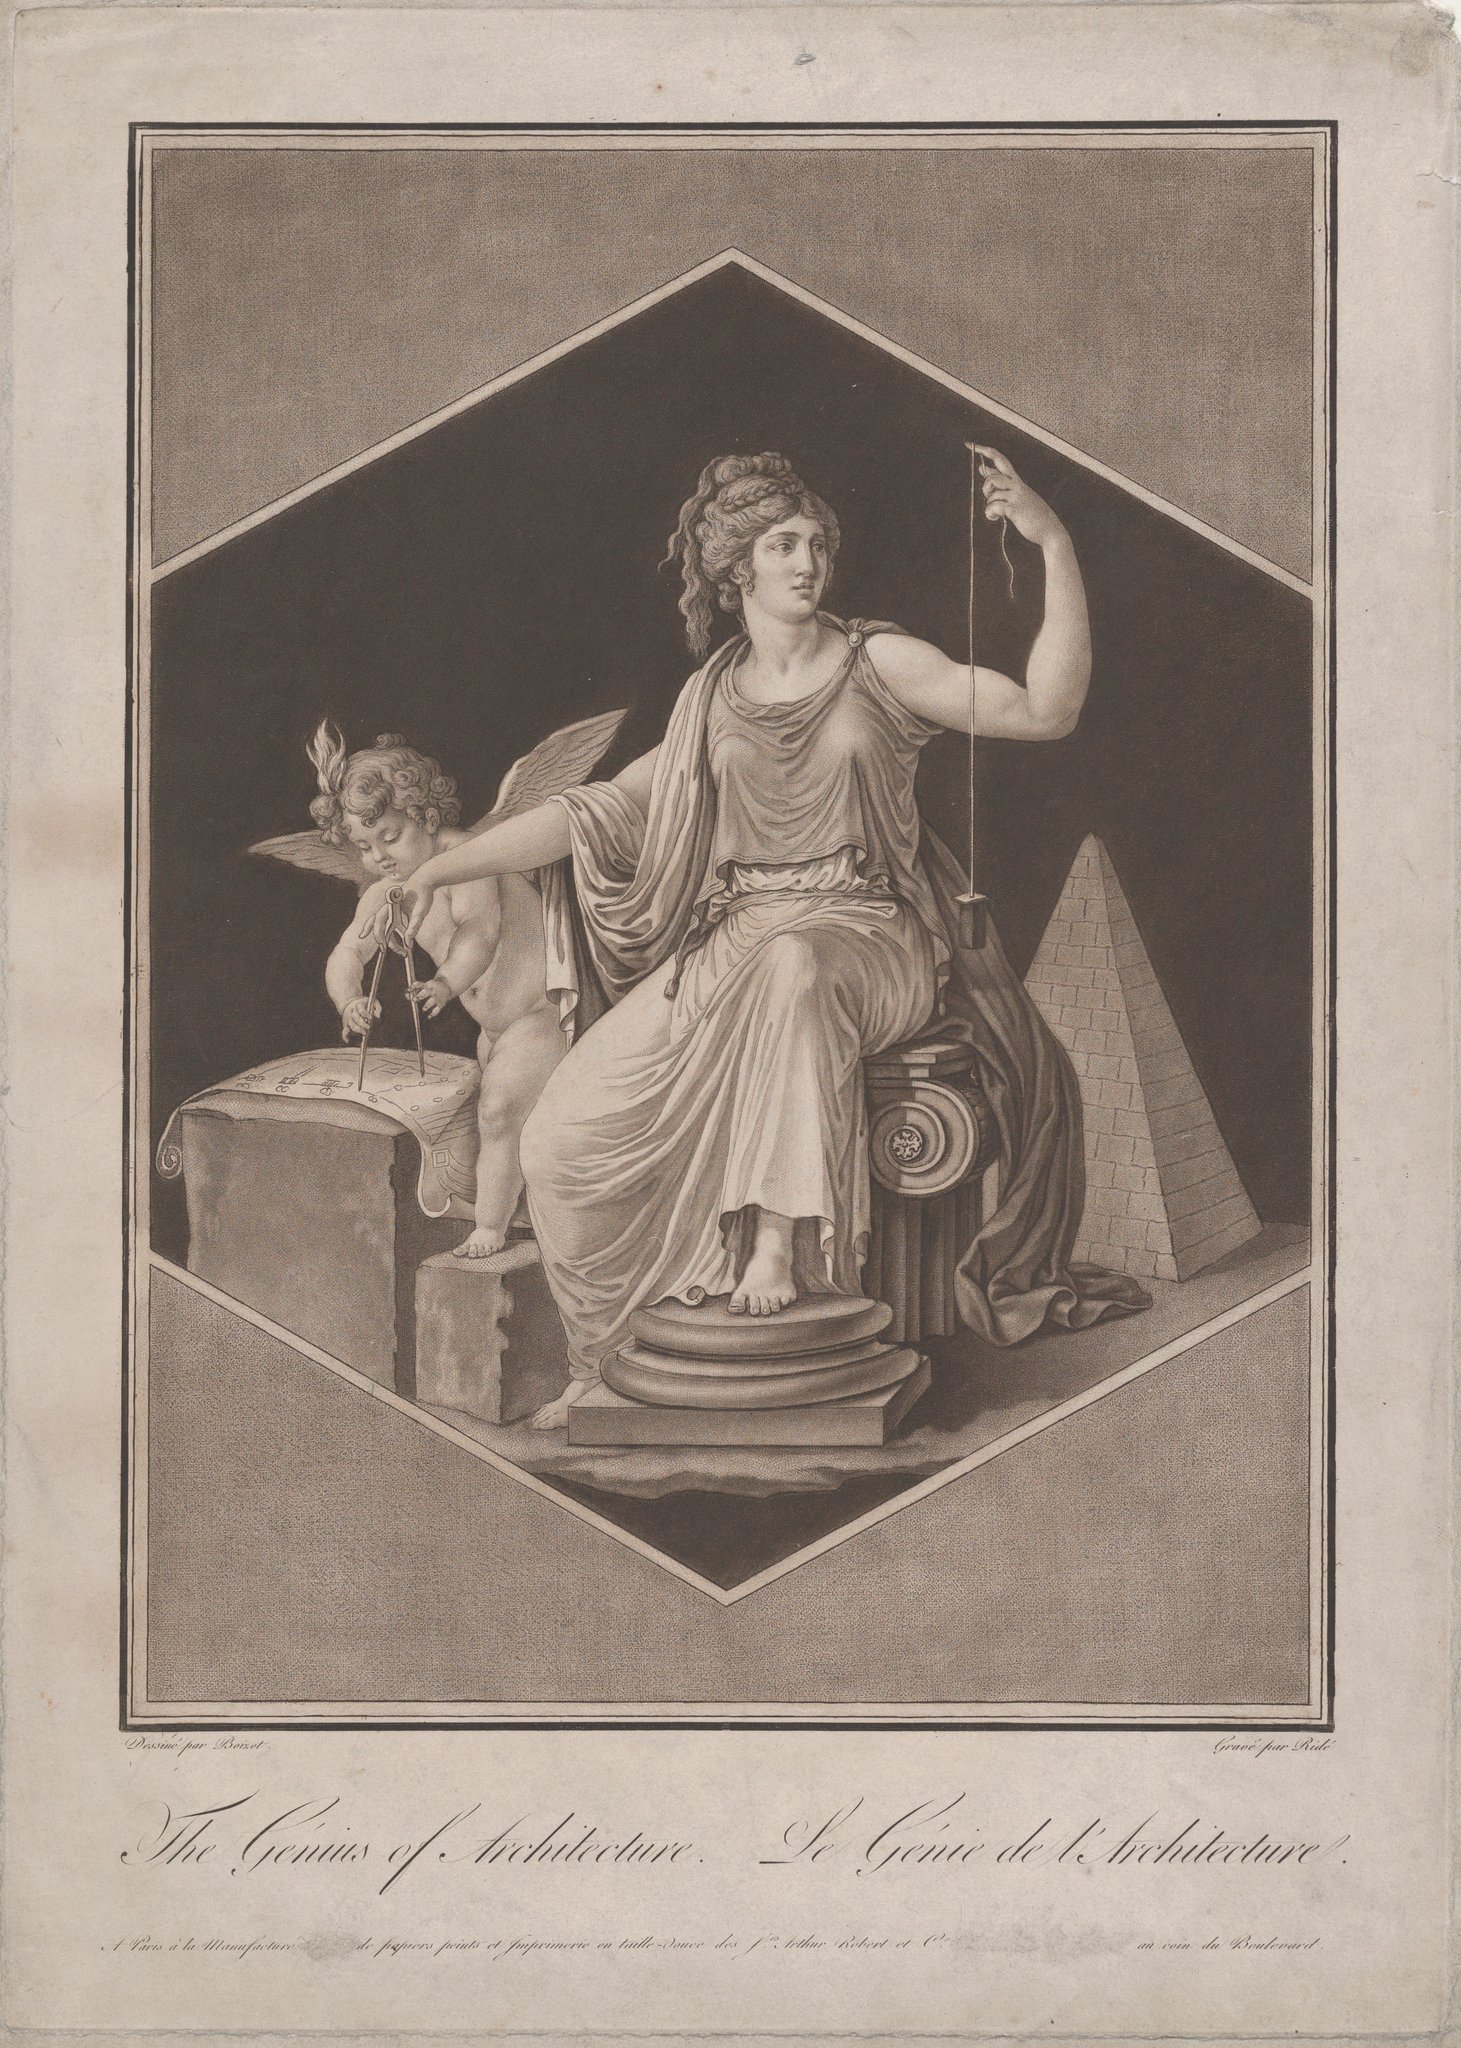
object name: print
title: The Genius of Architecture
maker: ridé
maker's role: engraver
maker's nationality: french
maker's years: 1780-1800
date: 1780-1800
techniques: engraving, etching